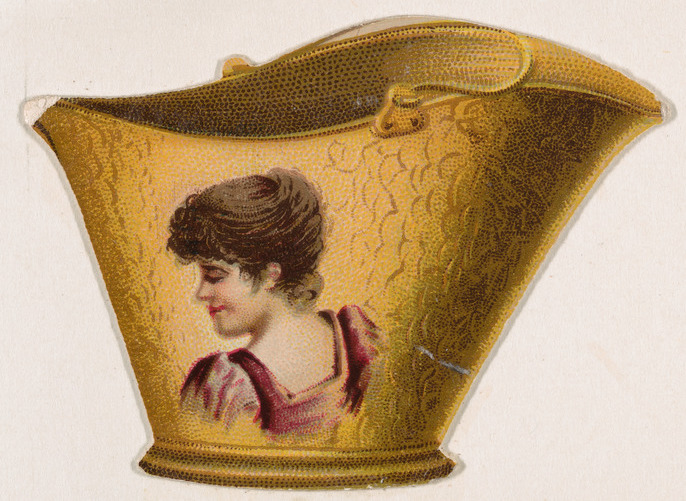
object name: print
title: Coal bucket, from the Novelties series (N228, Type 3) issued by Kinney Bros.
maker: kinney brothers tobacco company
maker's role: publisher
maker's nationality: american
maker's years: 1869-2011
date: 1889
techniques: color lithograph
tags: women,buckets